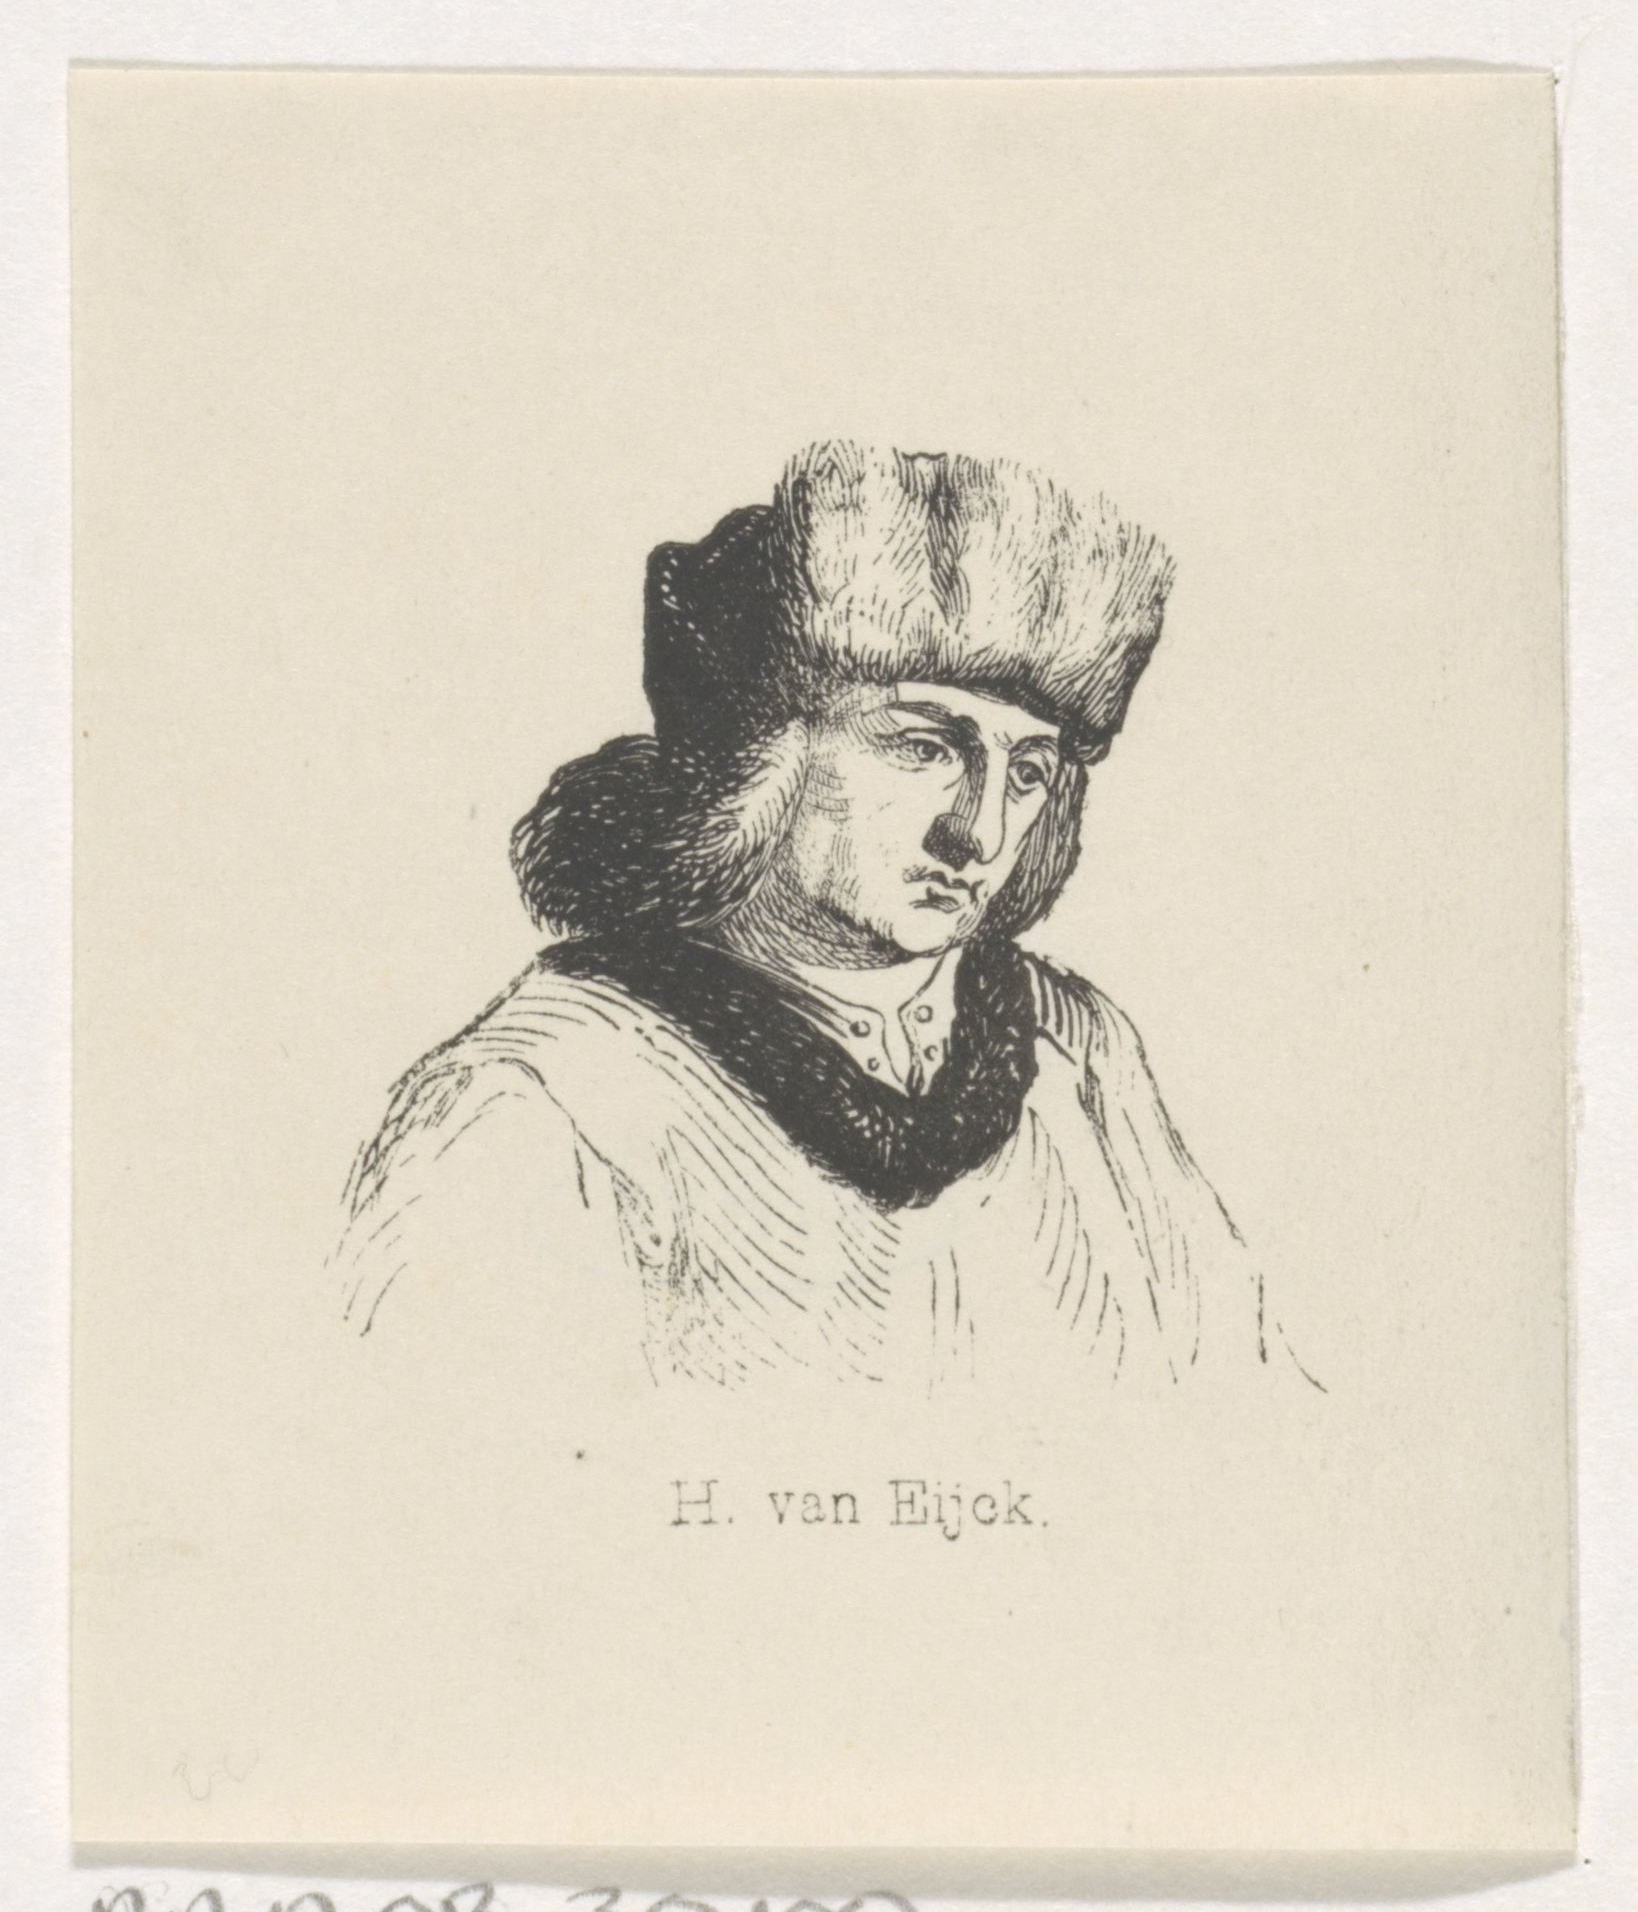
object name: book illustration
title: Portret van Hubert van Eijck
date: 1842-1843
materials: paper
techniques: engraving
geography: amsterdam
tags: painter, hubert van eyck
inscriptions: collector's mark: Lugt 2228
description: Prent uit: Immerzeel, Johannes. De levens en werken der Hollandsche en Vlaamsche kunstschilders, beeldhouwers, graveurs en bouwmeesters : van het begin der vijftiende eeuw tot heden. Amsterdam: J.C. van Kesteren, 1842-1843.